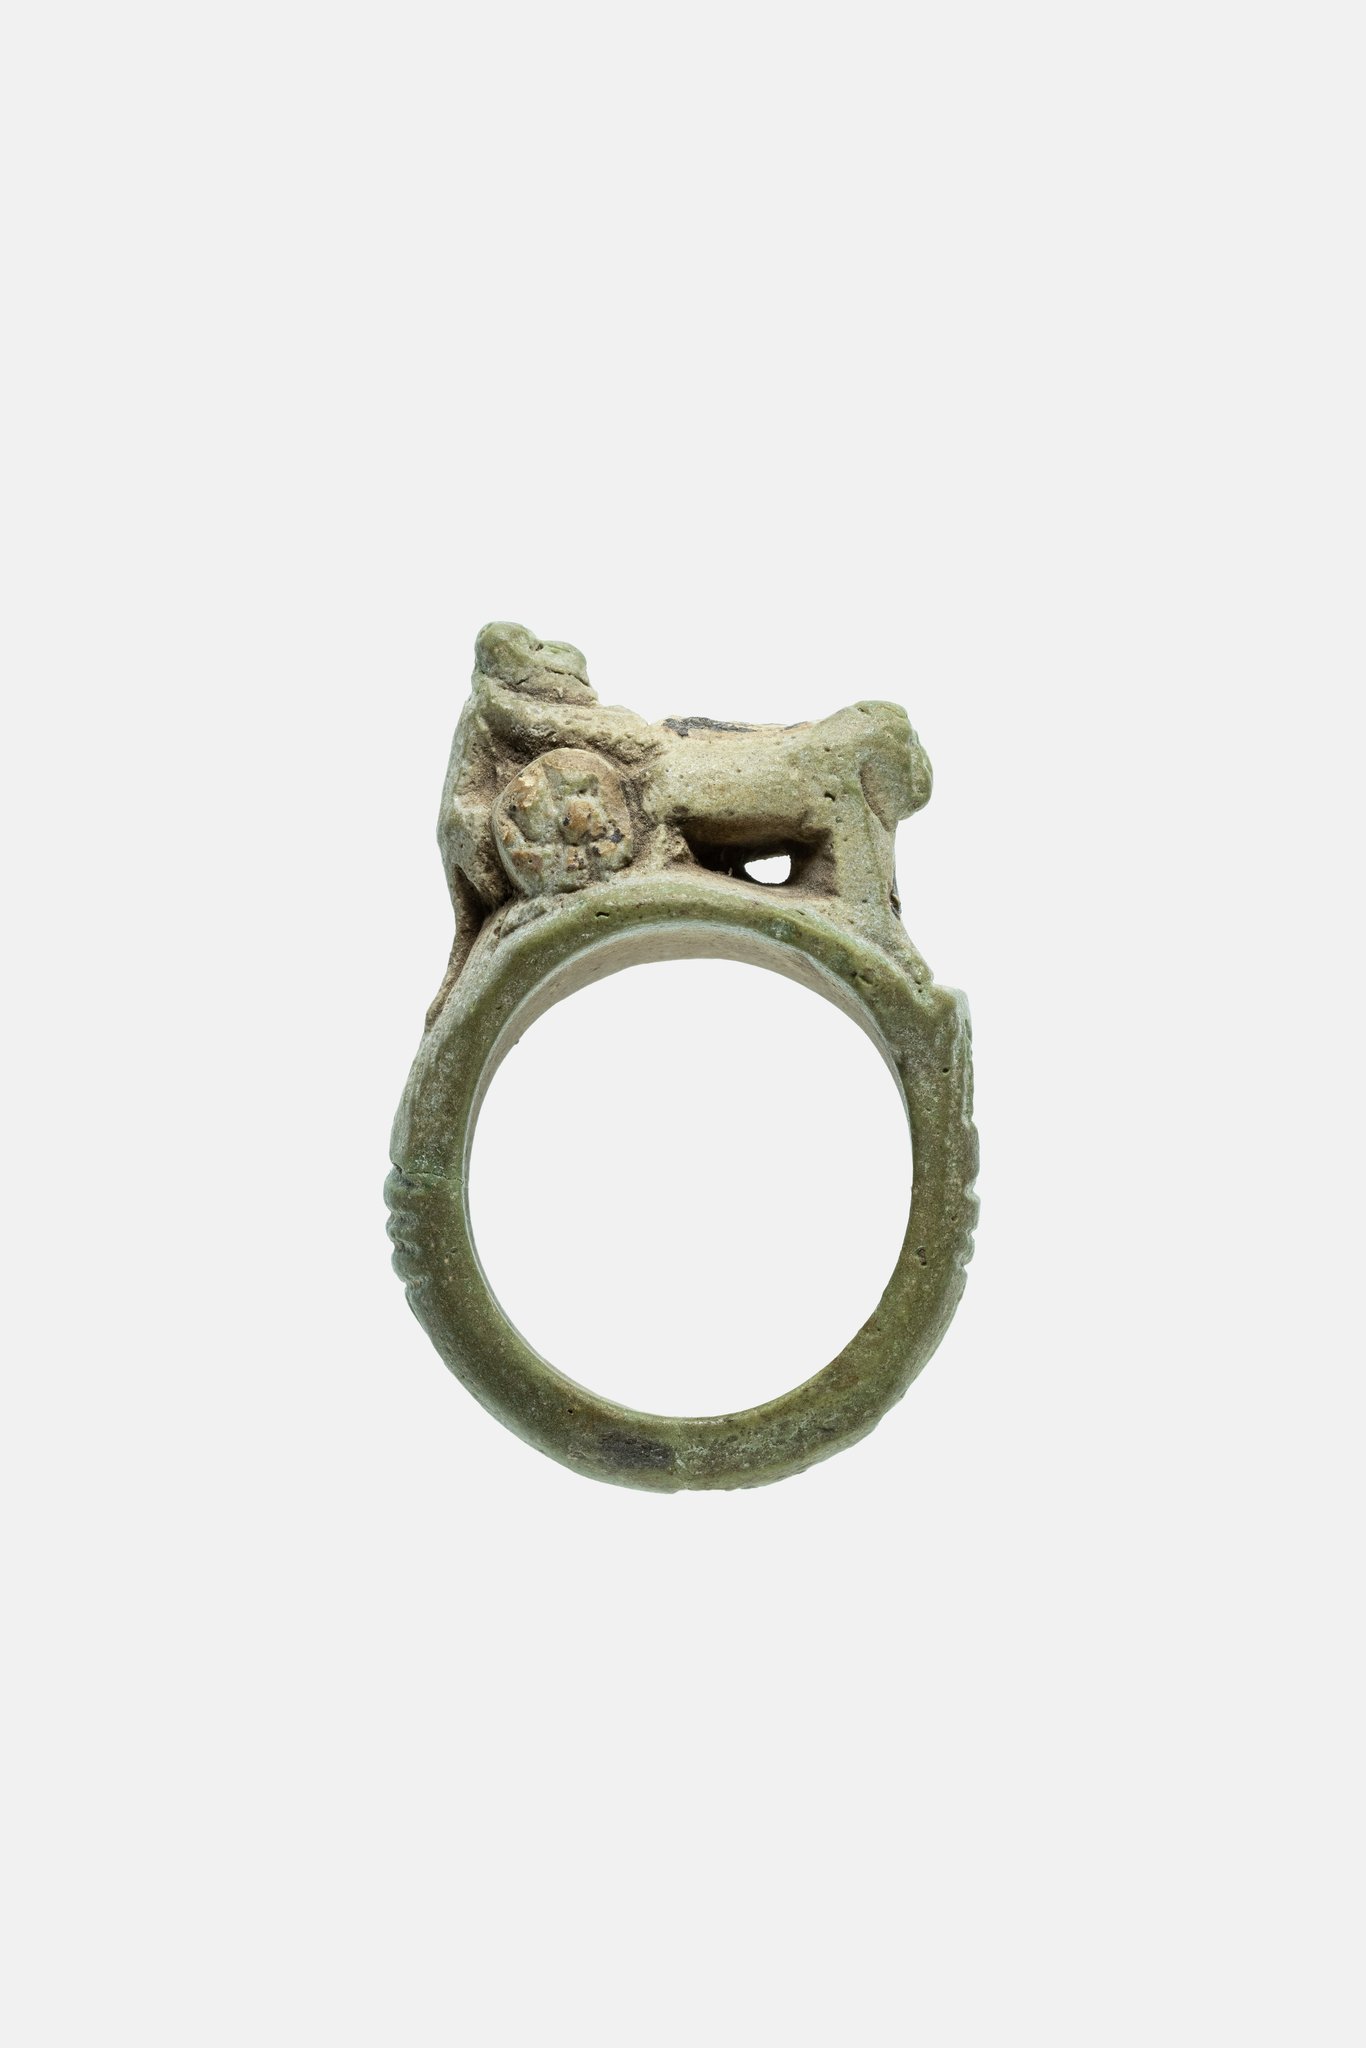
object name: ring, figure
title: Ring with a bezel in the form of a baboon in a chariot pulled by two lions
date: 1070-712 BCE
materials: faience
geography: egypt